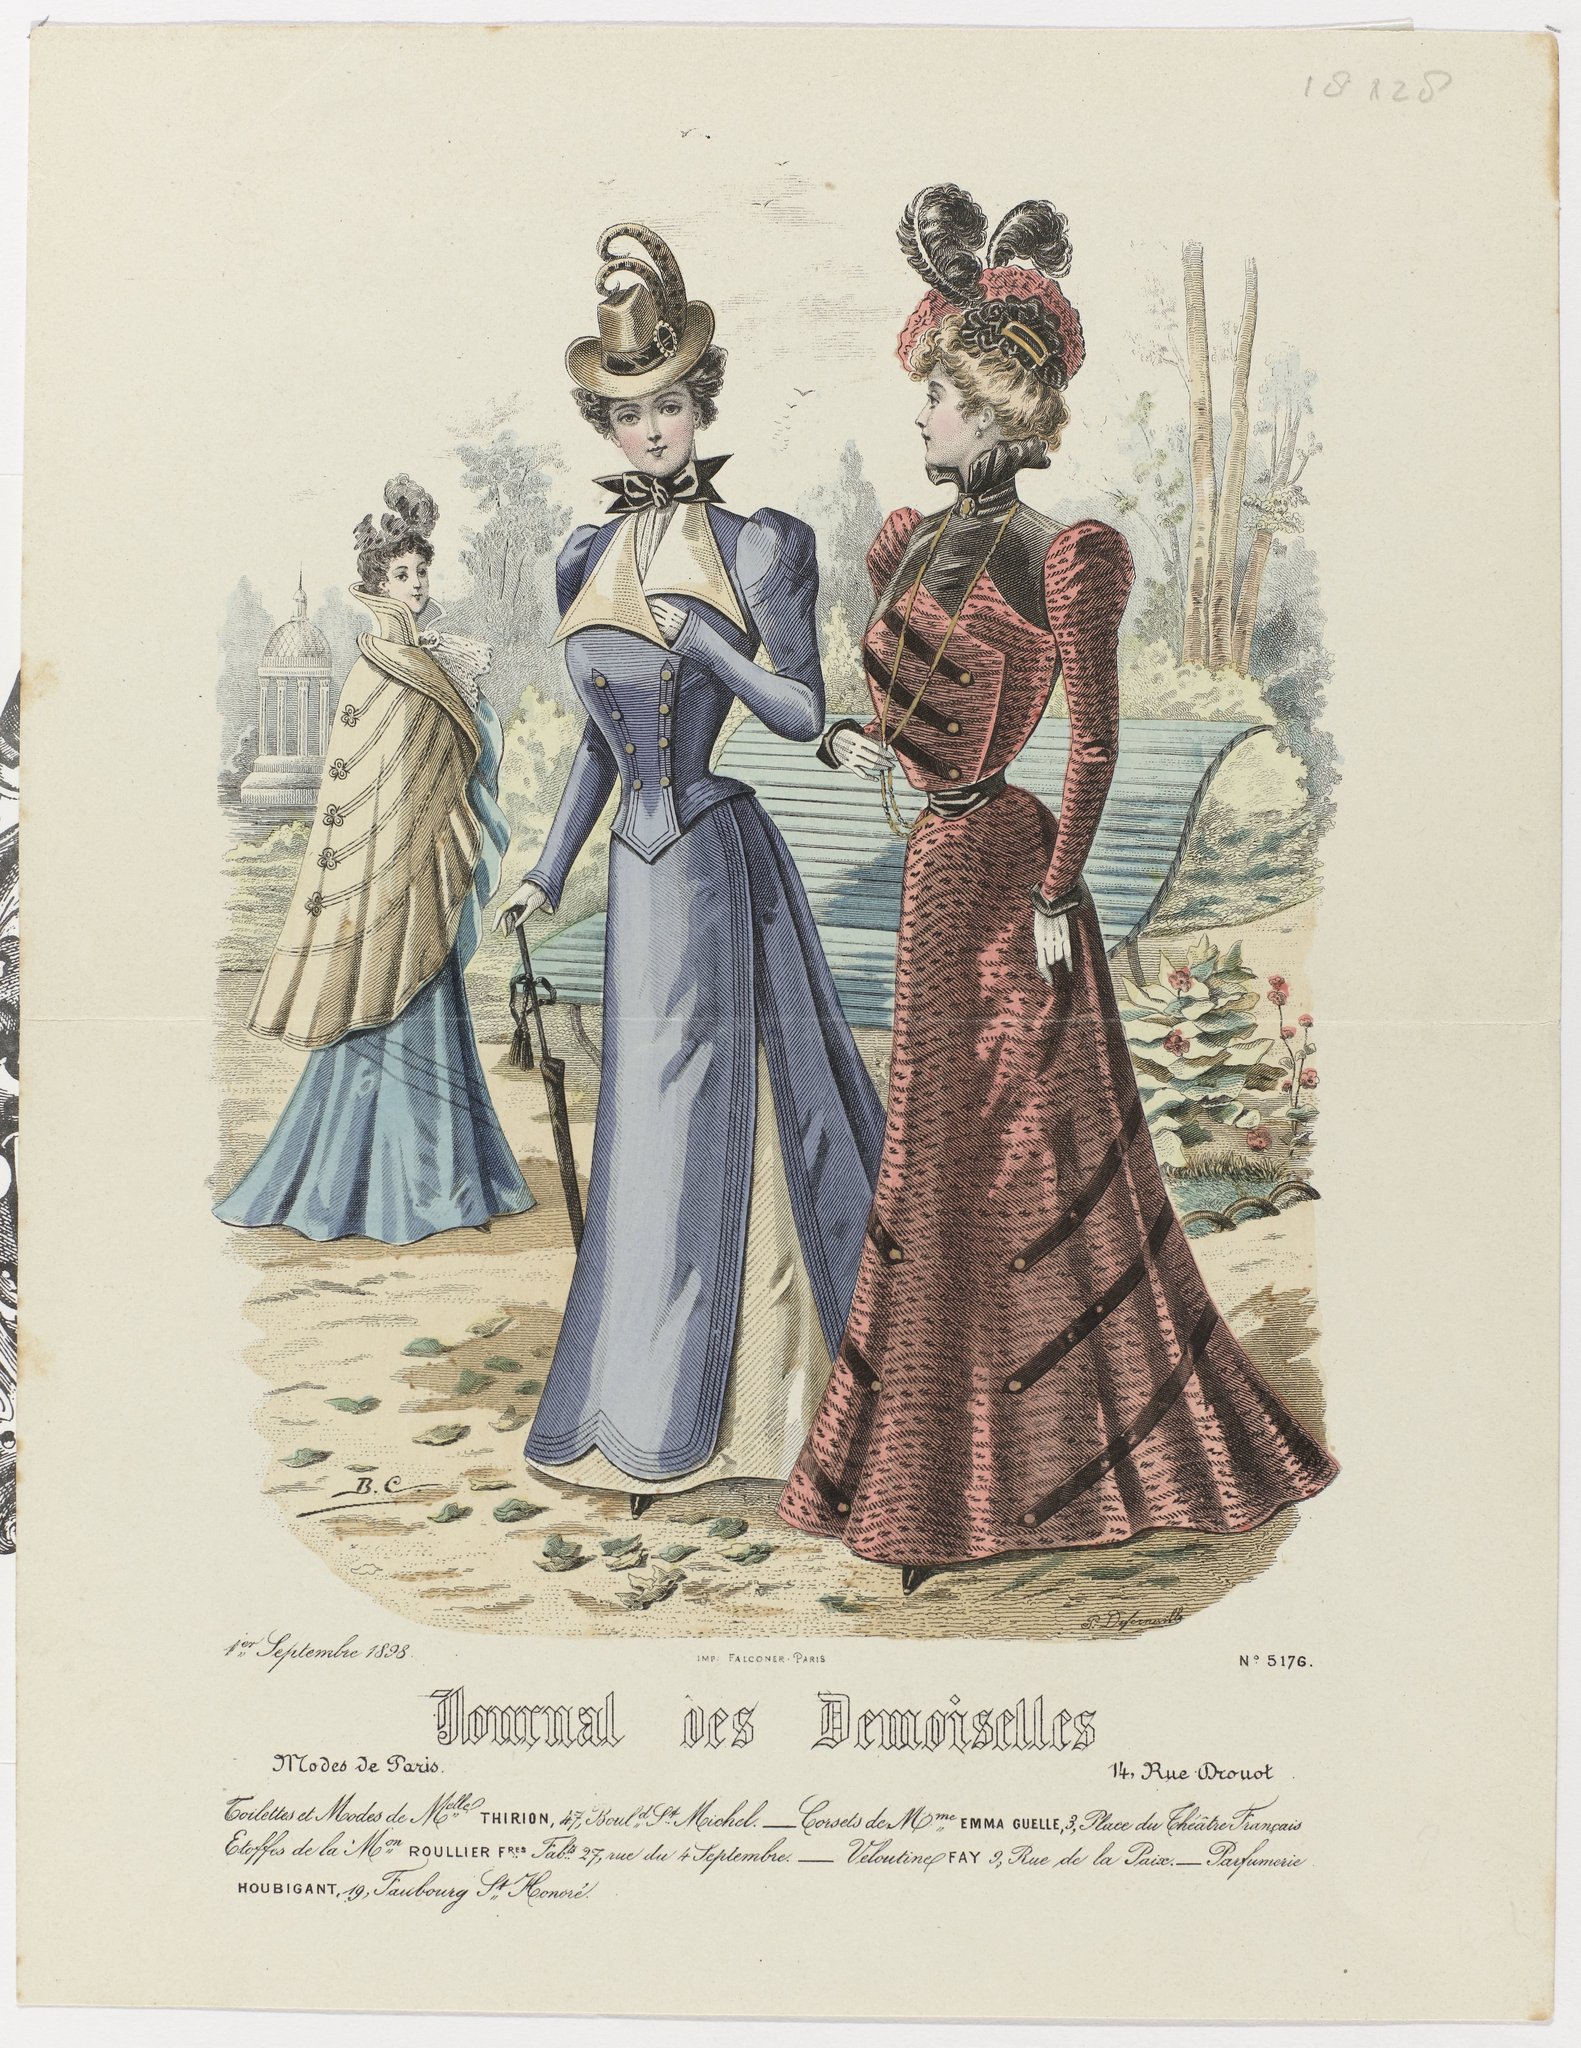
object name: fashion print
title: Journal des Demoiselles, 1 Septembre 1898, No. 5176 : Toilettes et Modes (...)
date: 1898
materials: paper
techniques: engraving, hand coloring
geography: paris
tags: park, bench, walking-stick, staff, cane (+ women's clothes), coat (+ women's clothes), fashion plates, head-gear: hat (+ women's clothes), skirt (+ women's clothes), dress, gown (+ women's clothes), necklace (+ women's clothes)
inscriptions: address: ‘14, Rue Drouot’, caption: ‘Toilettes et Modes de M.elle THIRION, 47, Boul.d S.t Michel _ Corsets de M.me EMMA GUELLE, 3, Place du Théâtre Français. Etoffes de la M.on ROULLIER F.res Fab.ts 27, rue du 4 Septembre. _ Veloutine FAY 9, Rue de la Piax_ Parfumerie HOUBIGANT,19, Faubourg S.t Honoré’, title: ‘Modes de Paris / Journal des Demoiselles’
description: Drie vrouwen wandelen in een park, op de achtergrond een tuinbank. Volgens het onderschrift: 'toilettes' en 'modes' van Thirion. Hieronder enkele regels reclametekst voor verschillende producten. Prent uit het modetijdschrift Journal des Demoiselles (1833 -1922).